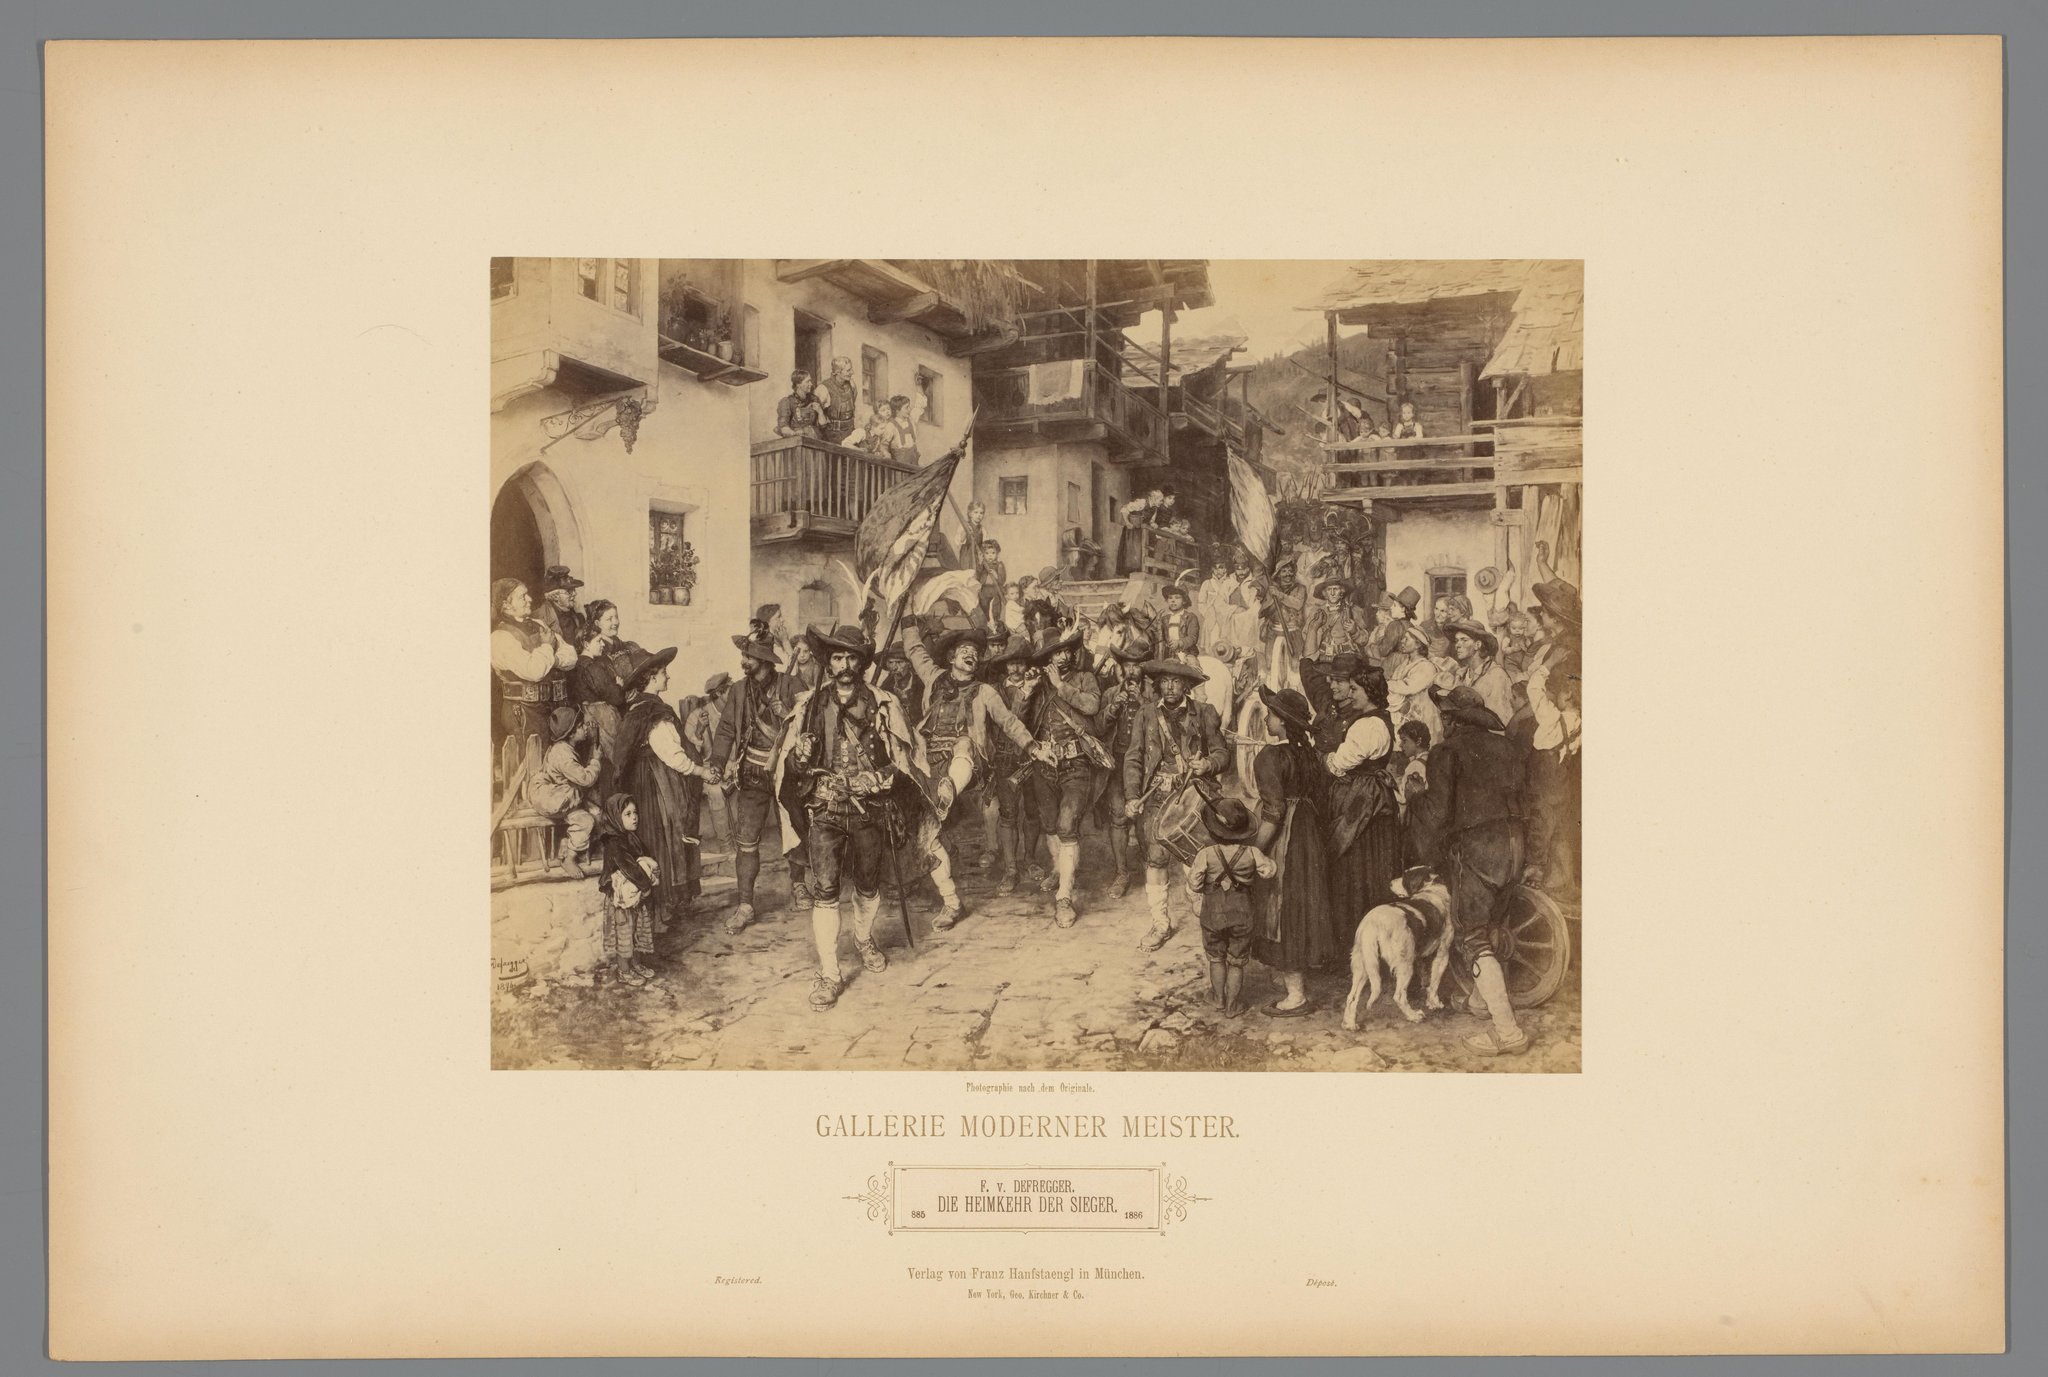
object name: photograph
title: Die Heimkehr der Sieger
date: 1886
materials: cardboard, photographic support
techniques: albumen print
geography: munich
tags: conqueror triumphing, triumphal entry of victor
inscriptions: inscription: ‘Photographie nach dem Originale.’, inscription: ‘F. v. DEGREFFER/ DIE HEIMKEHR DER SIEGER./ 885 - 1886’, inscription: ‘Registered. - Déposé.’